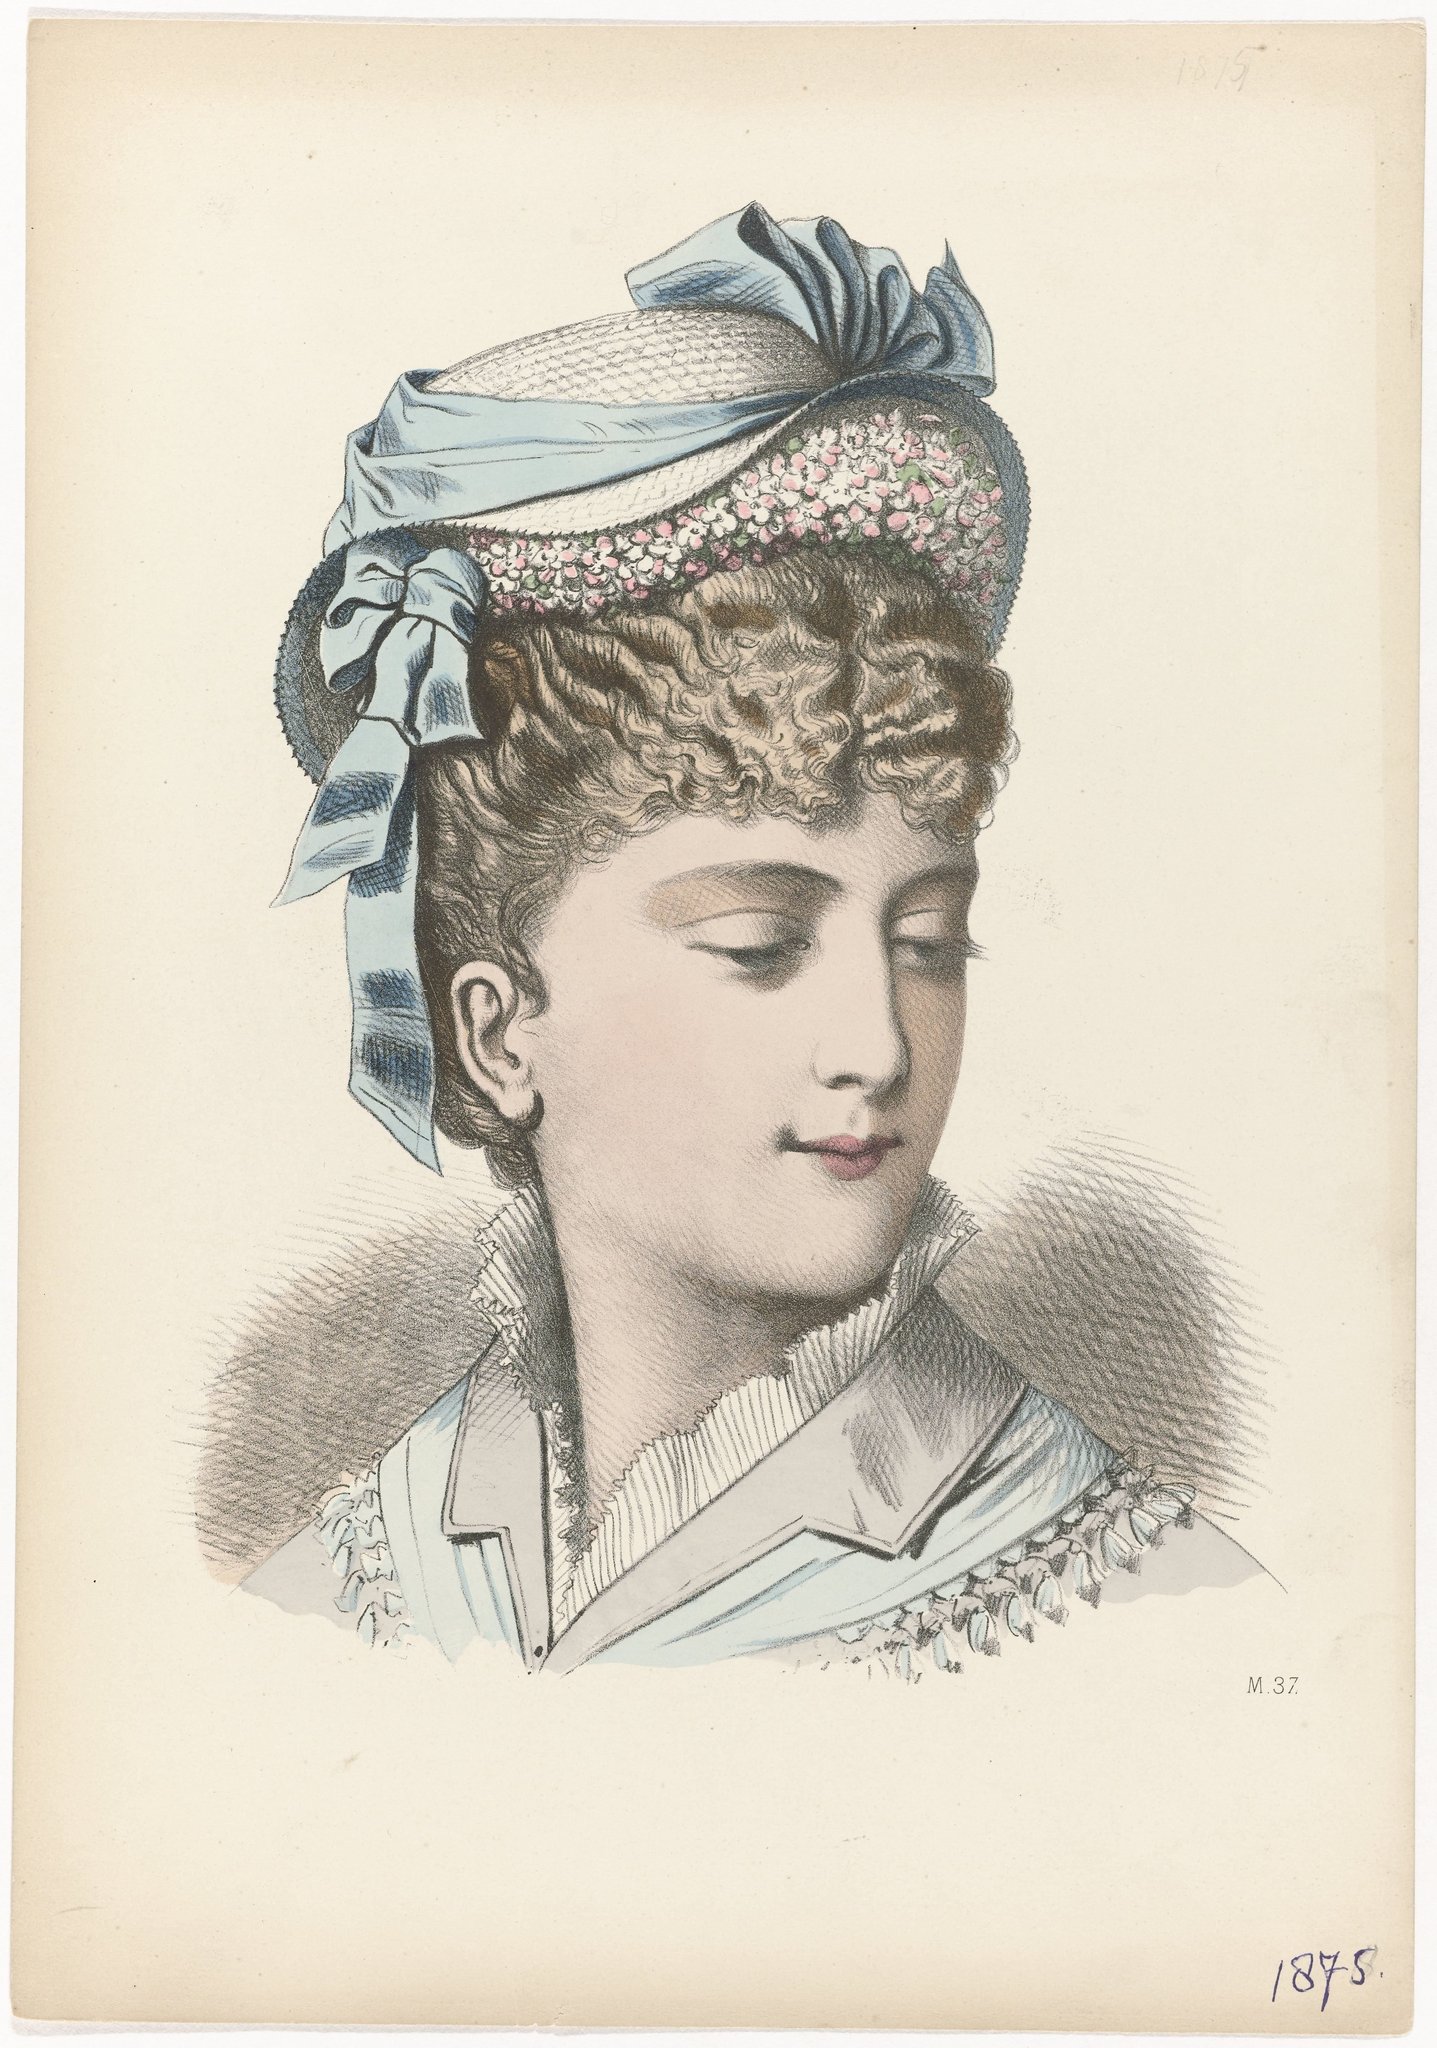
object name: fashion print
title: Vrouwenhoofd met hoed, 1875, No. M.37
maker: Anonymous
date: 1875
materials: paper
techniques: hand coloring, lithograph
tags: flowers, border, ribbon, braid (+ women's clothes), head-gear (+ women's clothes), neck-gear: collar (+ women's clothes), fashion plates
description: Buste van vrouw met een hoed versierd met bloemen en linten. Opstaande gerimpelde kraag.